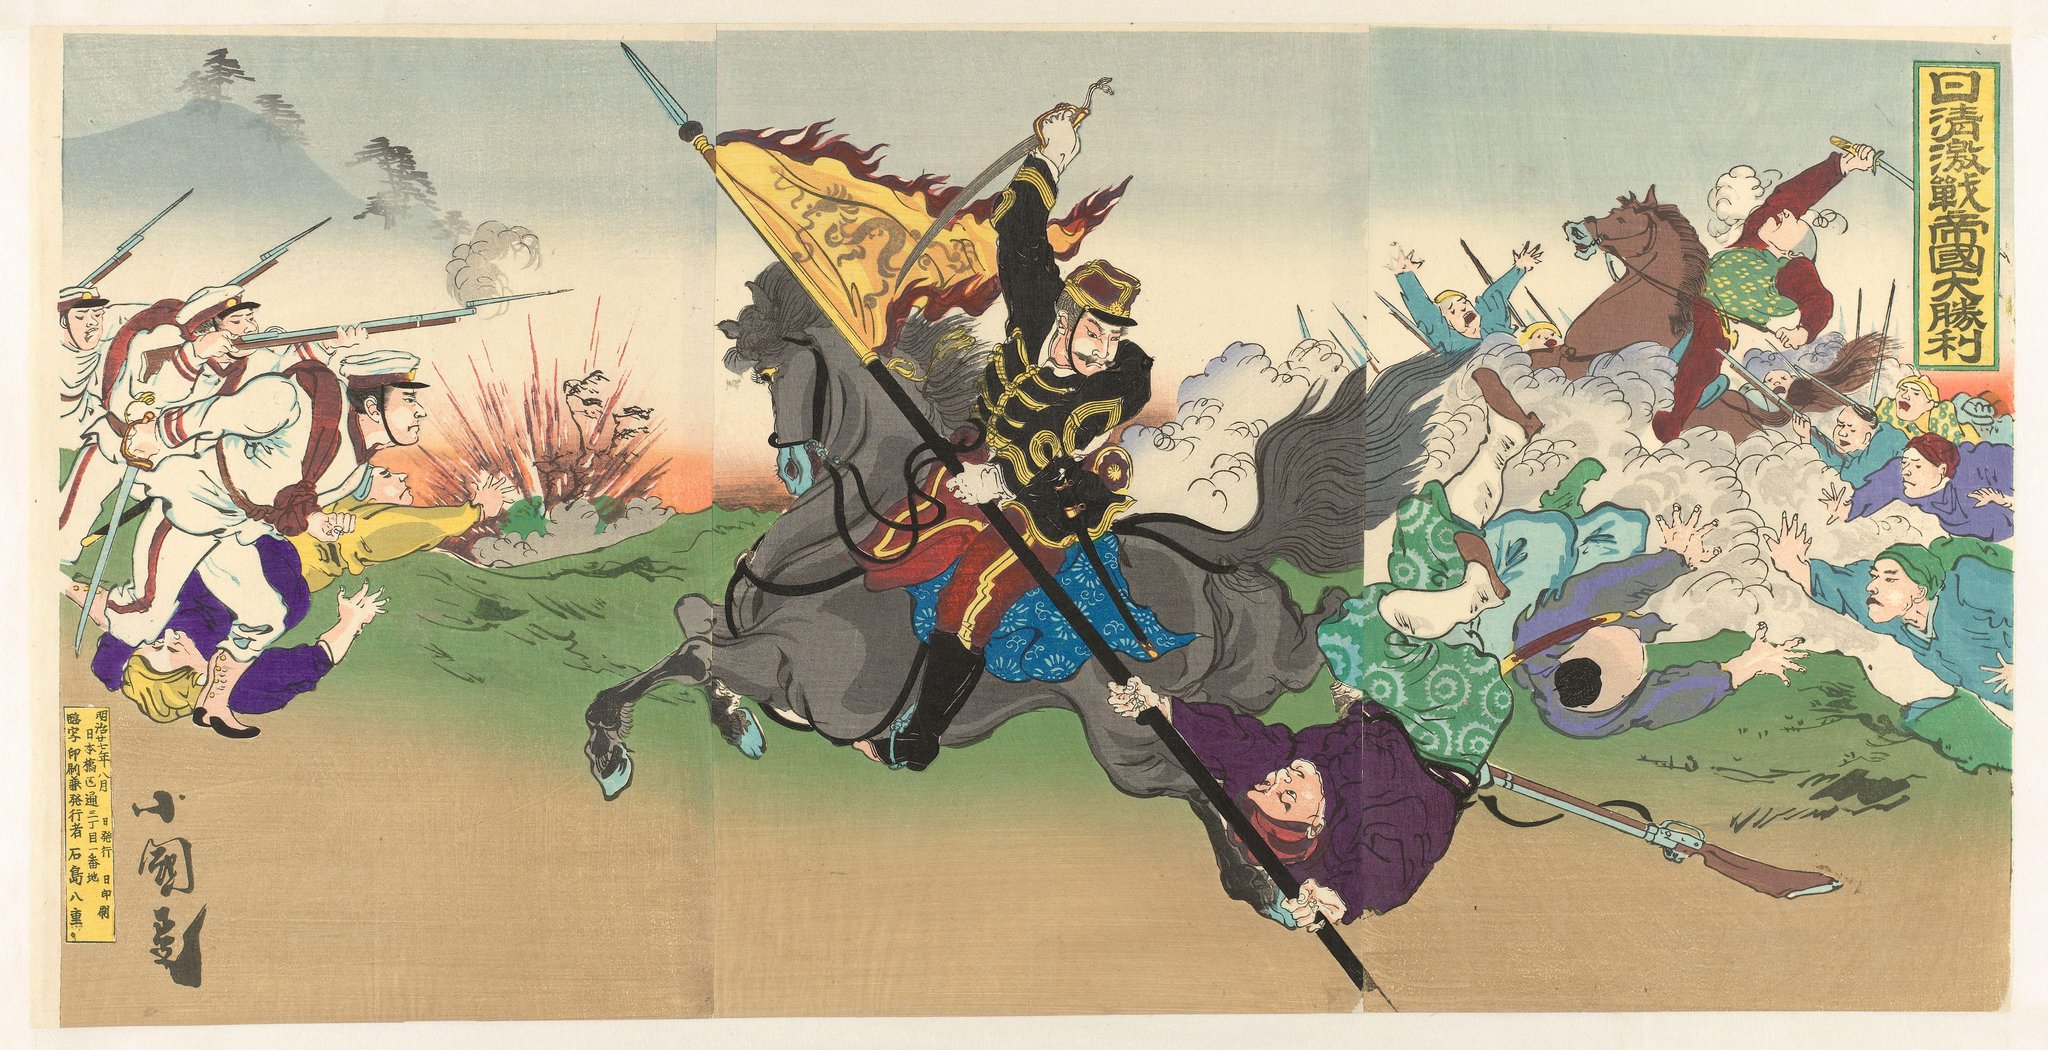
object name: triptych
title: Nisshin gekisen teikoku daishôri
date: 1894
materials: paper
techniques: woodcut, polish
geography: japan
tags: battle, (military) standard-bearer, (military) flags and standards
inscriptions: label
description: Een Japanse generaal grijpt naar de vlaggenstok van een Chinese soldaat, vanaf links stormen de Japanse soldaten richting het gevecht.